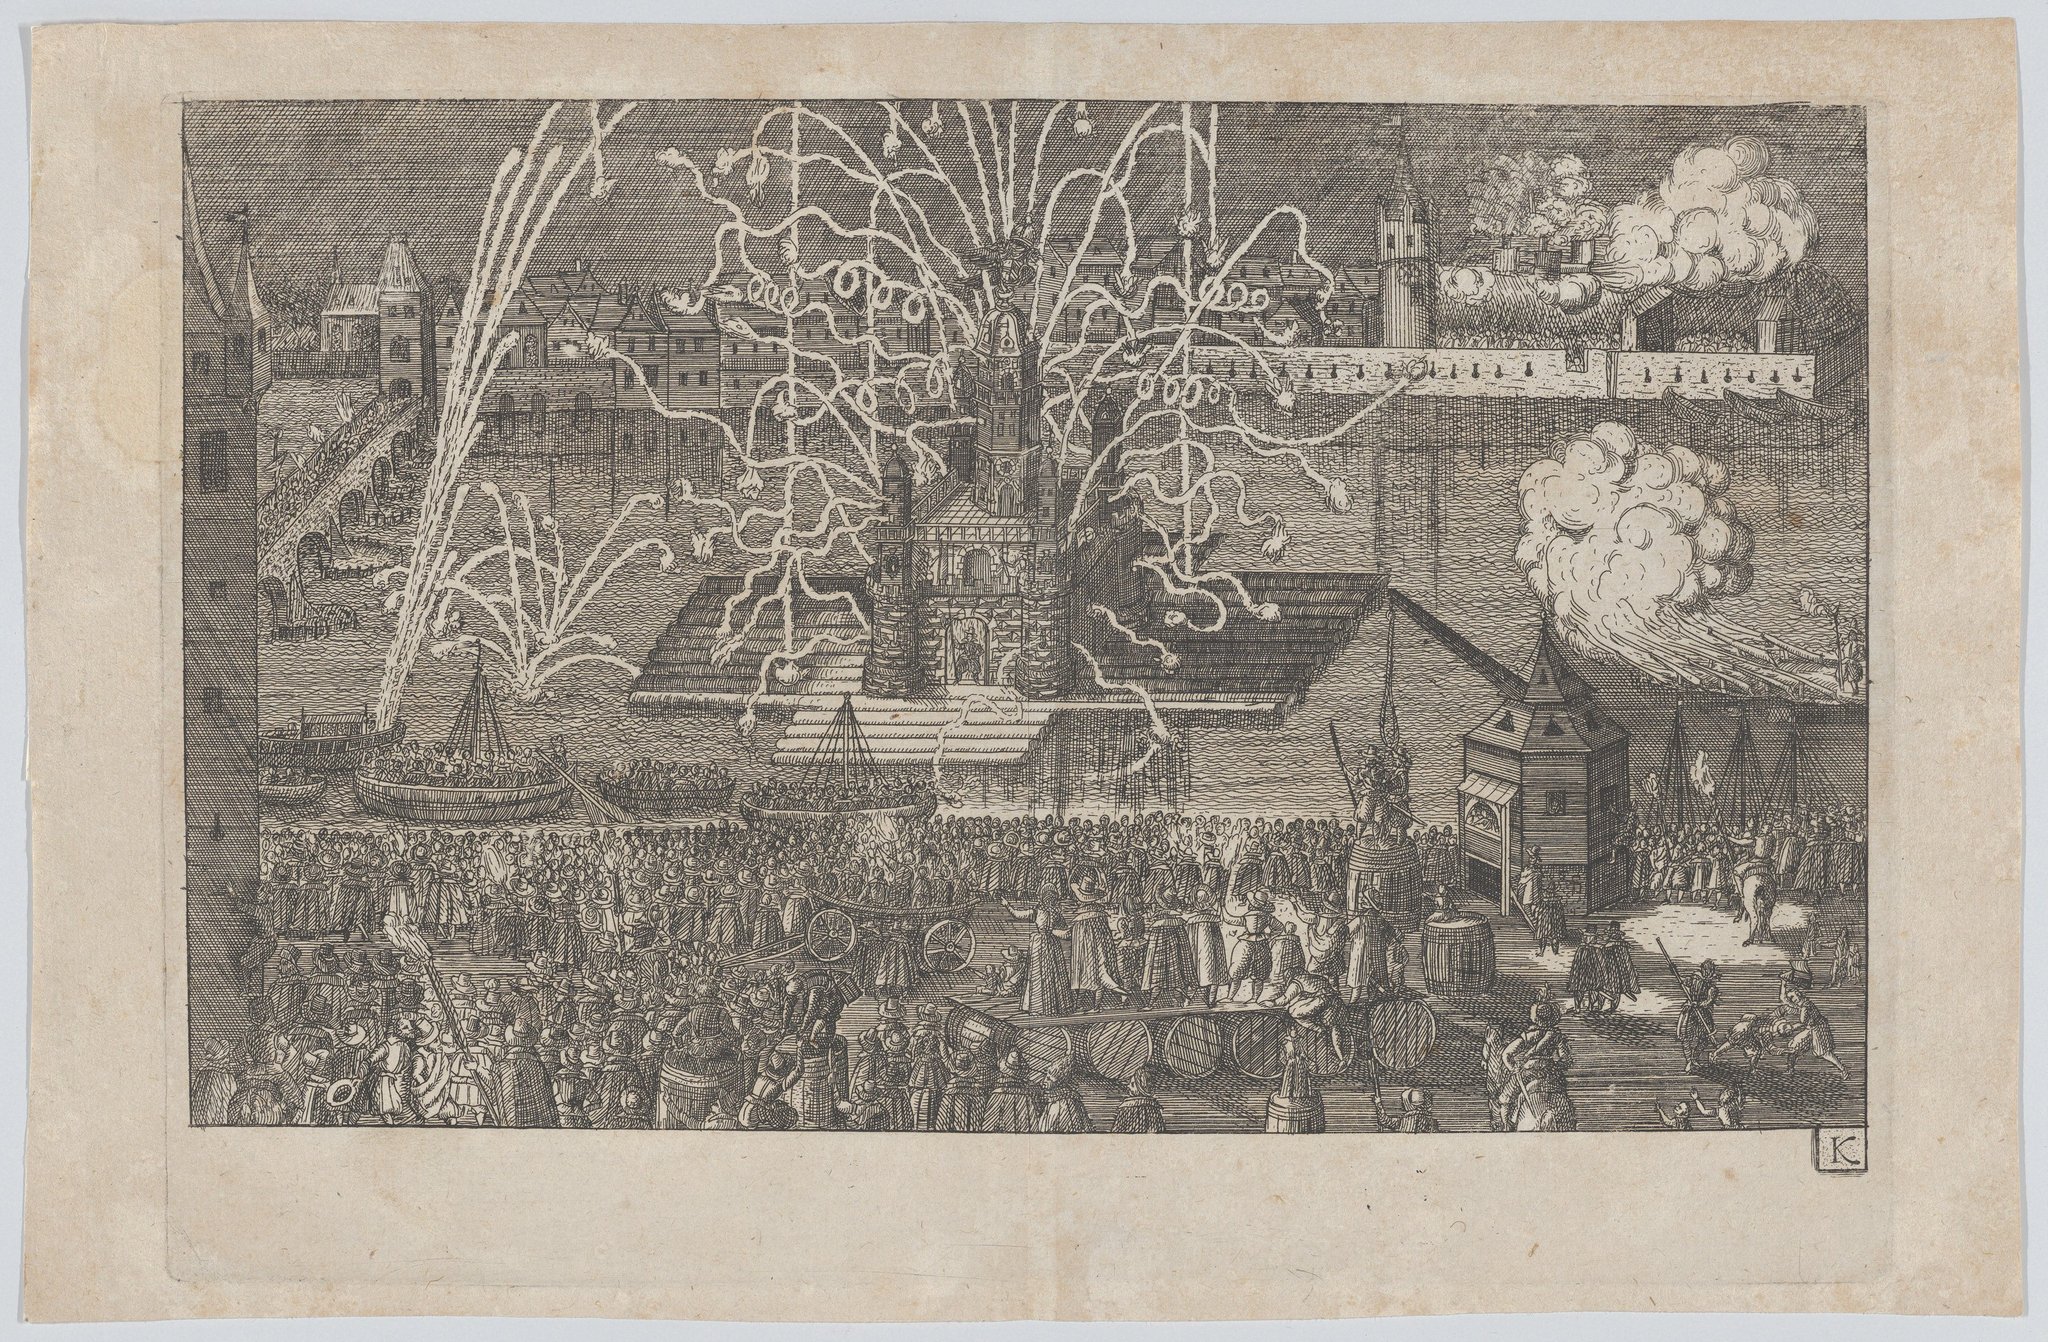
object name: print, fete, ornament architecture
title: Plate K: Election and Coronation of Emperor Maximilian II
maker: anonymous, german, 17th century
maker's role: publisher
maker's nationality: german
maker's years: 1600-1700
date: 1612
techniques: etching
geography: frankfurt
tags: elections,fireworks,crowd